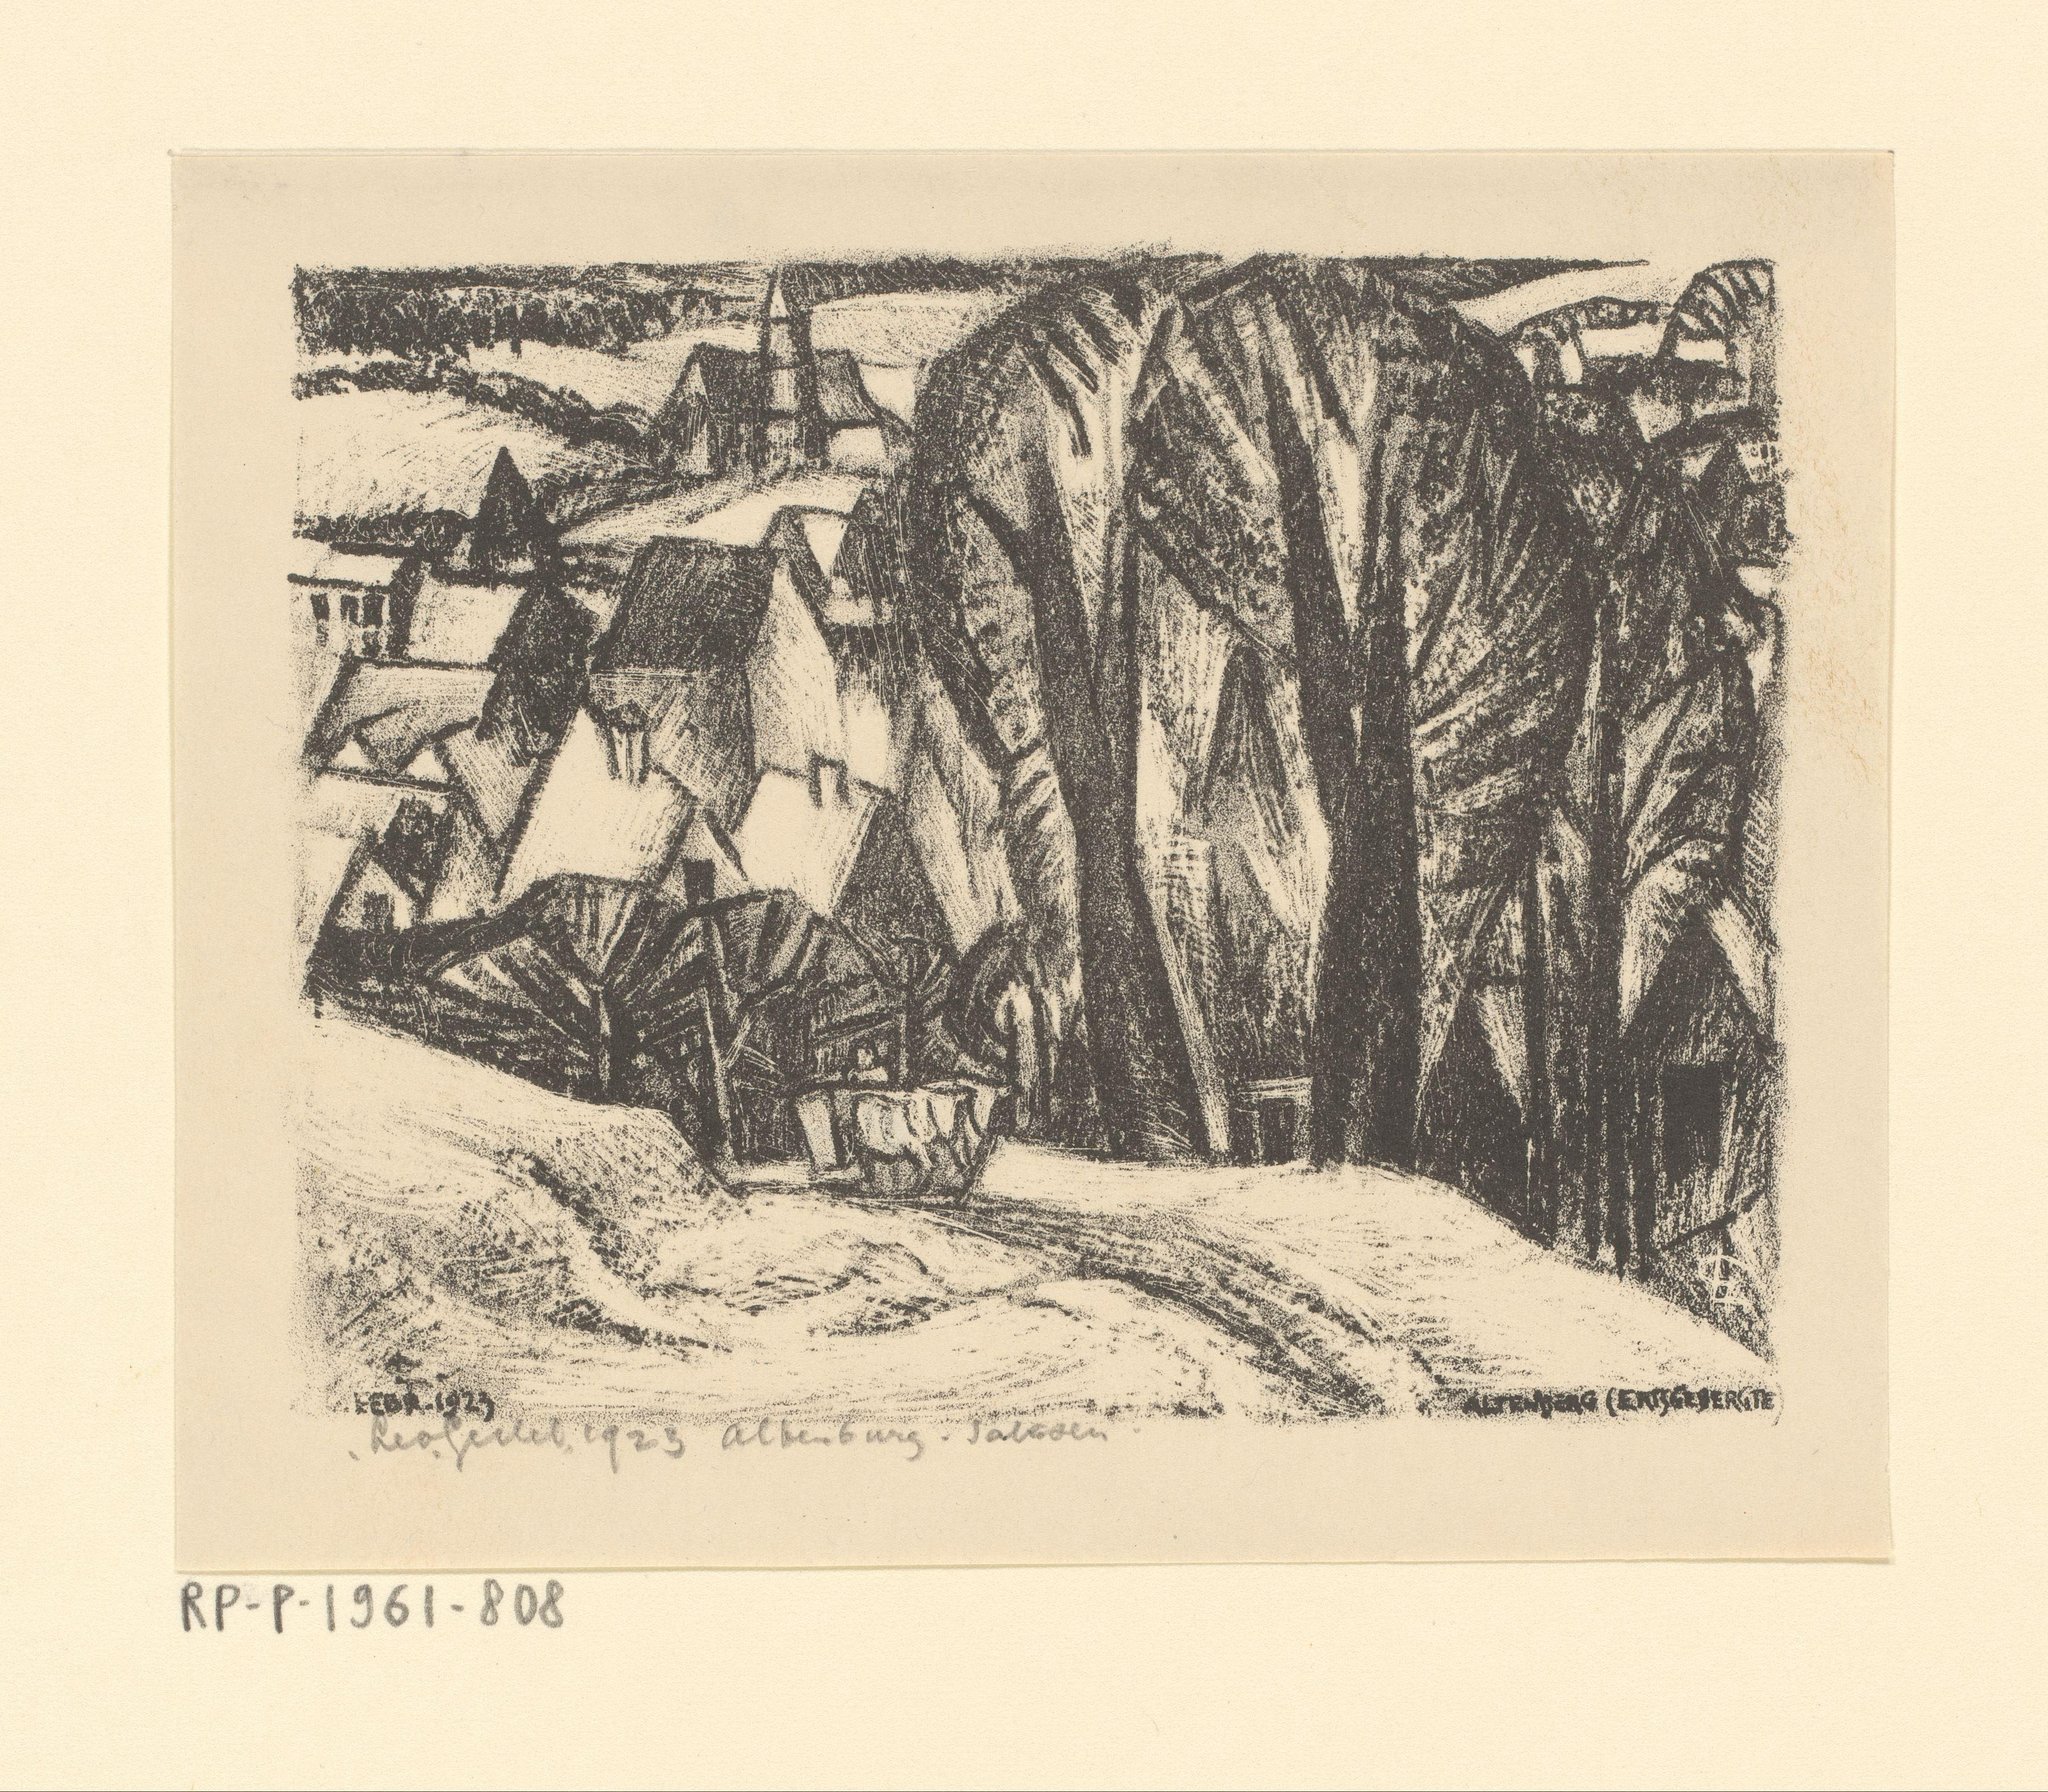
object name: print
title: Altenberg (Ertsgebergte)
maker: leo gestel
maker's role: draughtsman, print maker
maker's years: 1881-1941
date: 1902-1923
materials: paper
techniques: lithograph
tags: city-view, and landscape with man-made constructions, snow, ox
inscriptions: collector's mark: Lugt 2228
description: Zicht op de stad Altenberg in het Duitse Saksen vanaf een heuvel. Op de heuvel een ossenkar. Het landschap is besneeuwd.